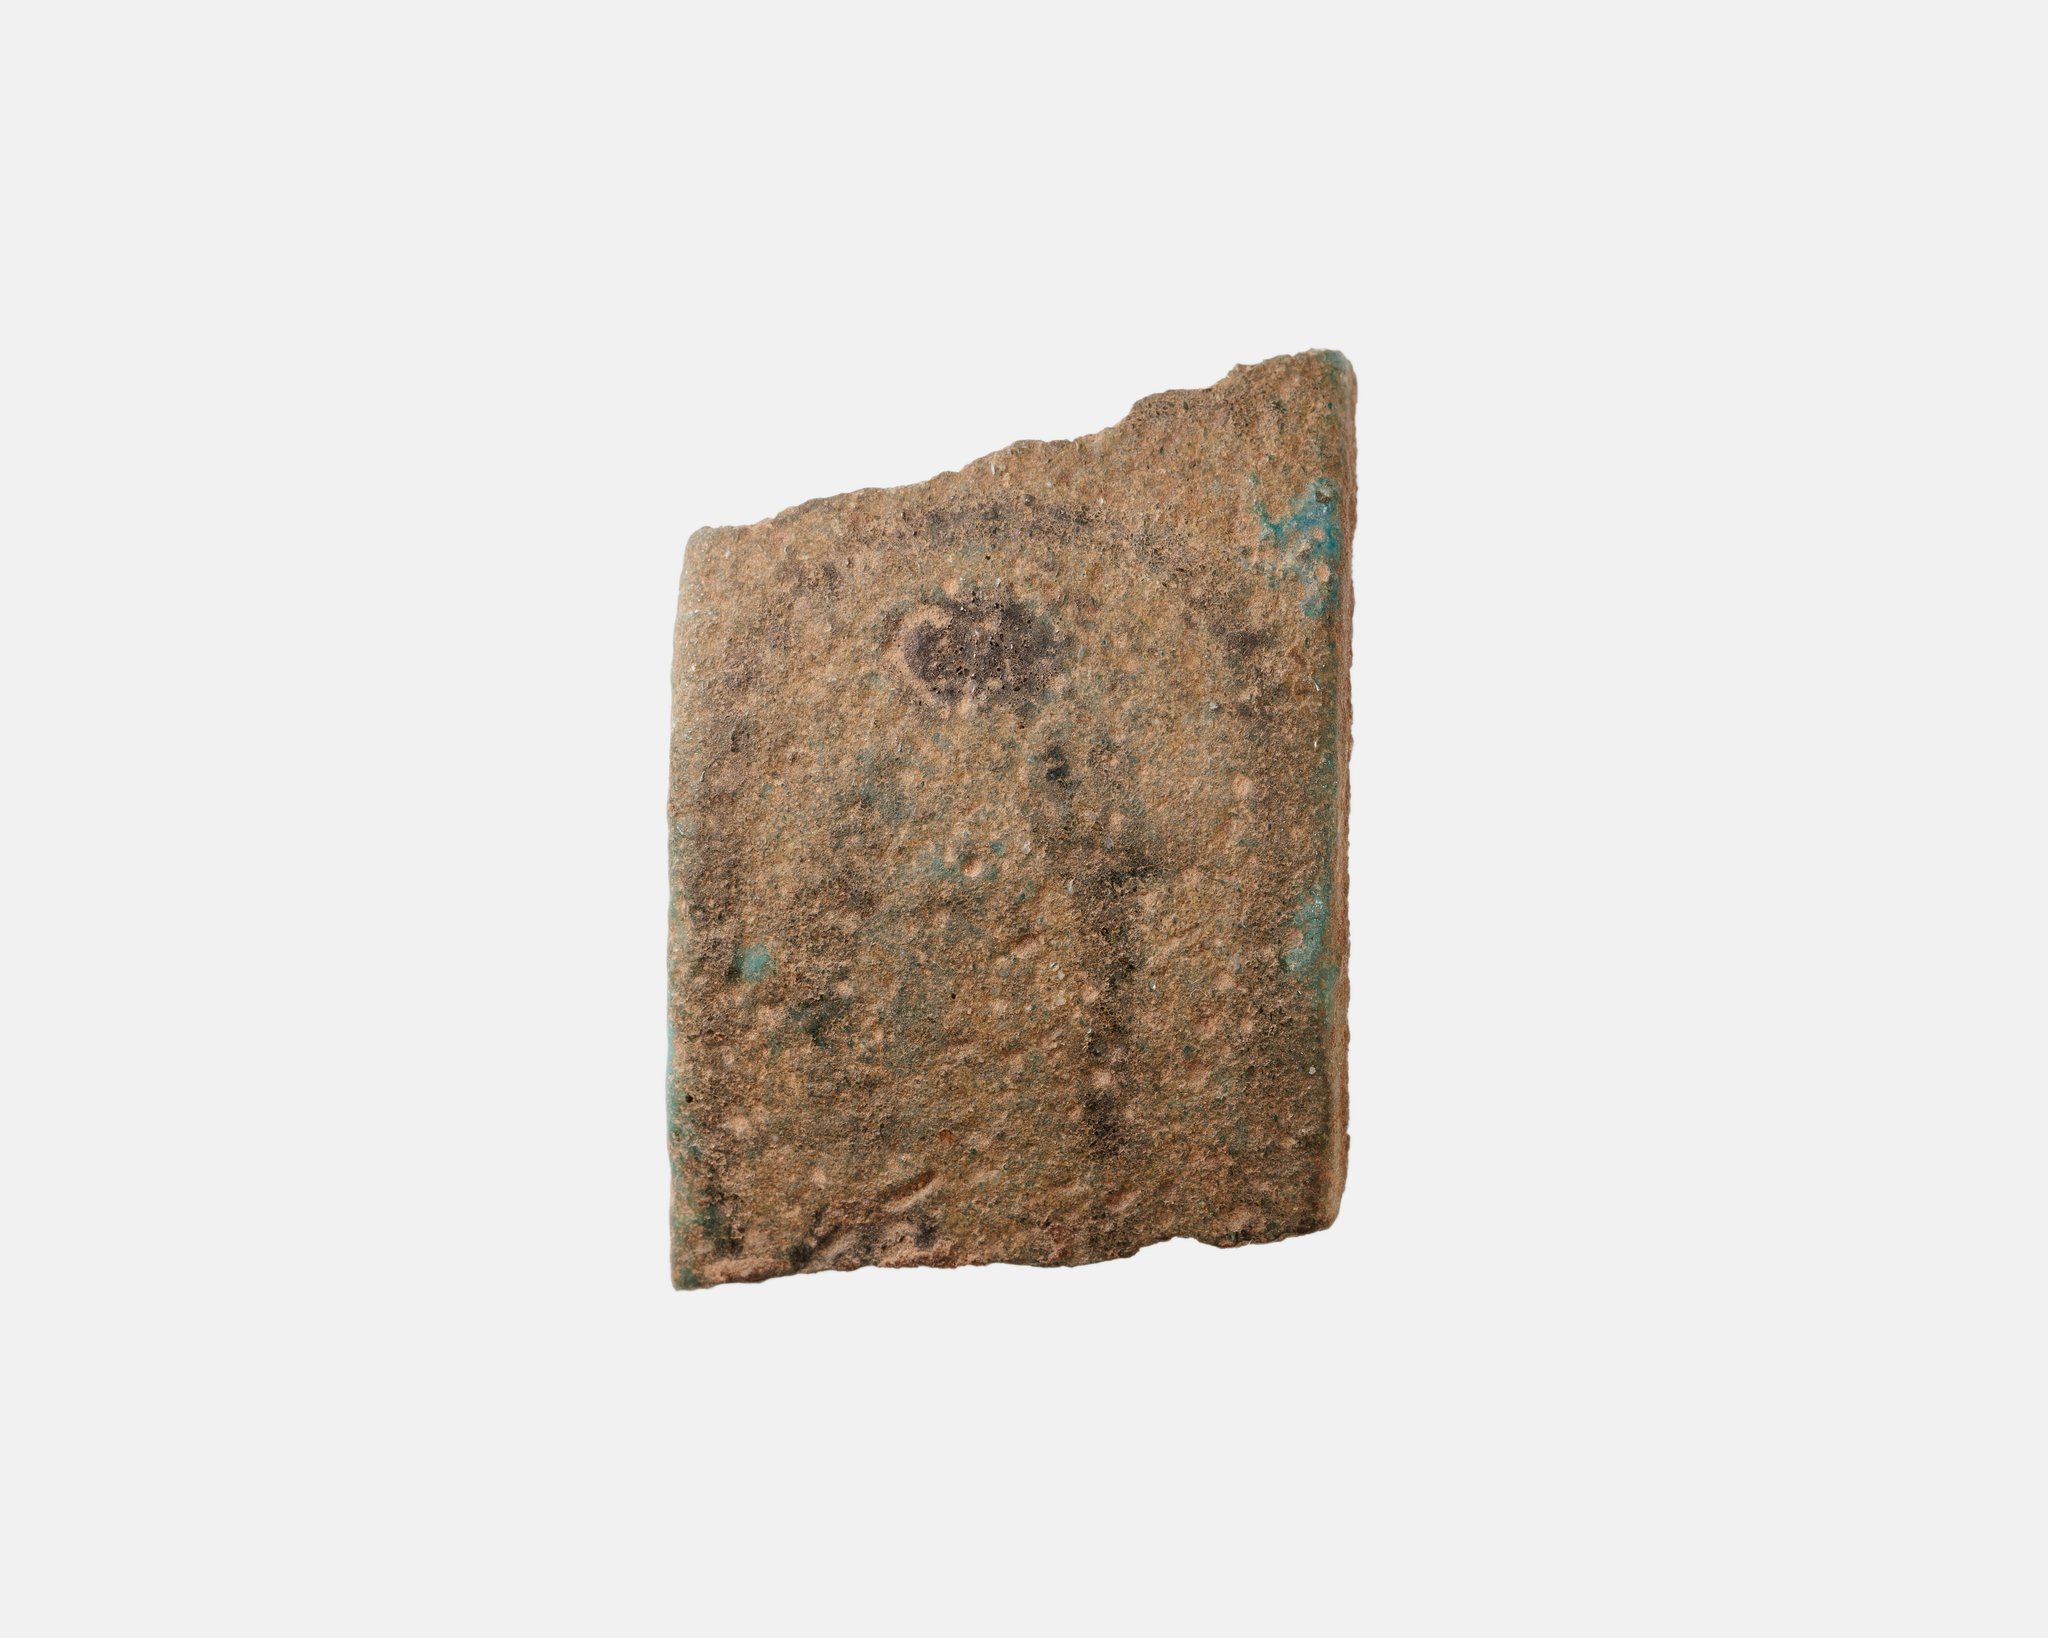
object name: votive bracelet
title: Fragment of a votive bracelet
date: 1295-1070 BCE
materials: faience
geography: egypt